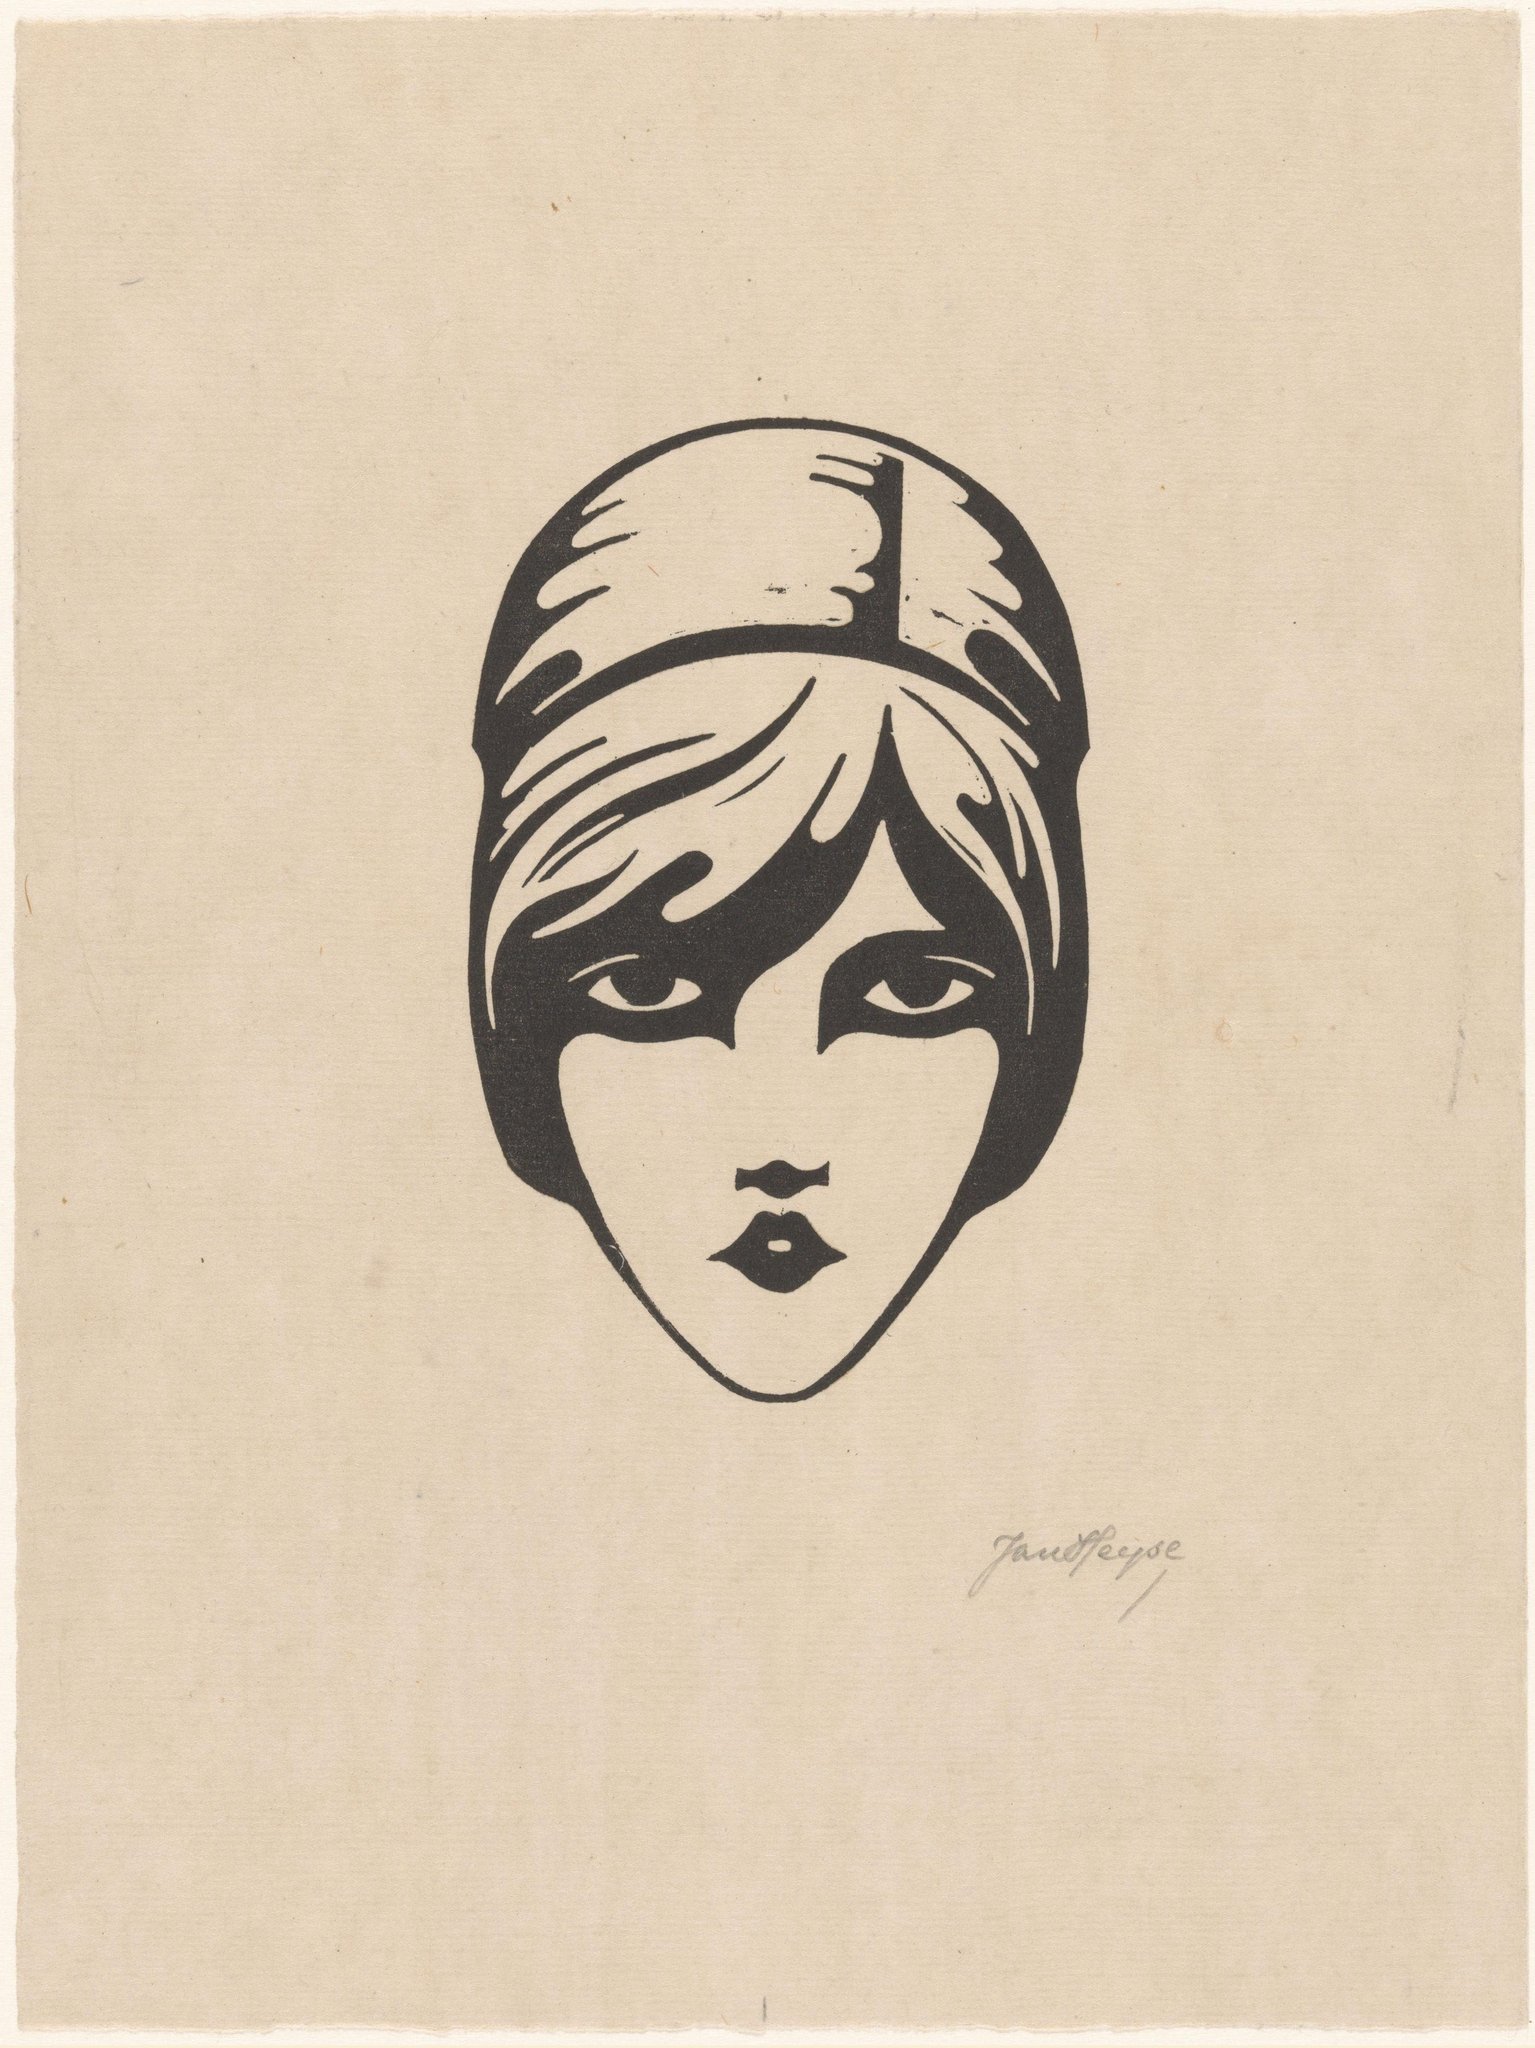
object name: print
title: Gezicht van een jonge vrouw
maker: jan heyse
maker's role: painter, print maker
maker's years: 1882-1954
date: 1892-1931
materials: paper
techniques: woodcut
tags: adolescent, young woman, maiden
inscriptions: collector's mark: Lugt 2228